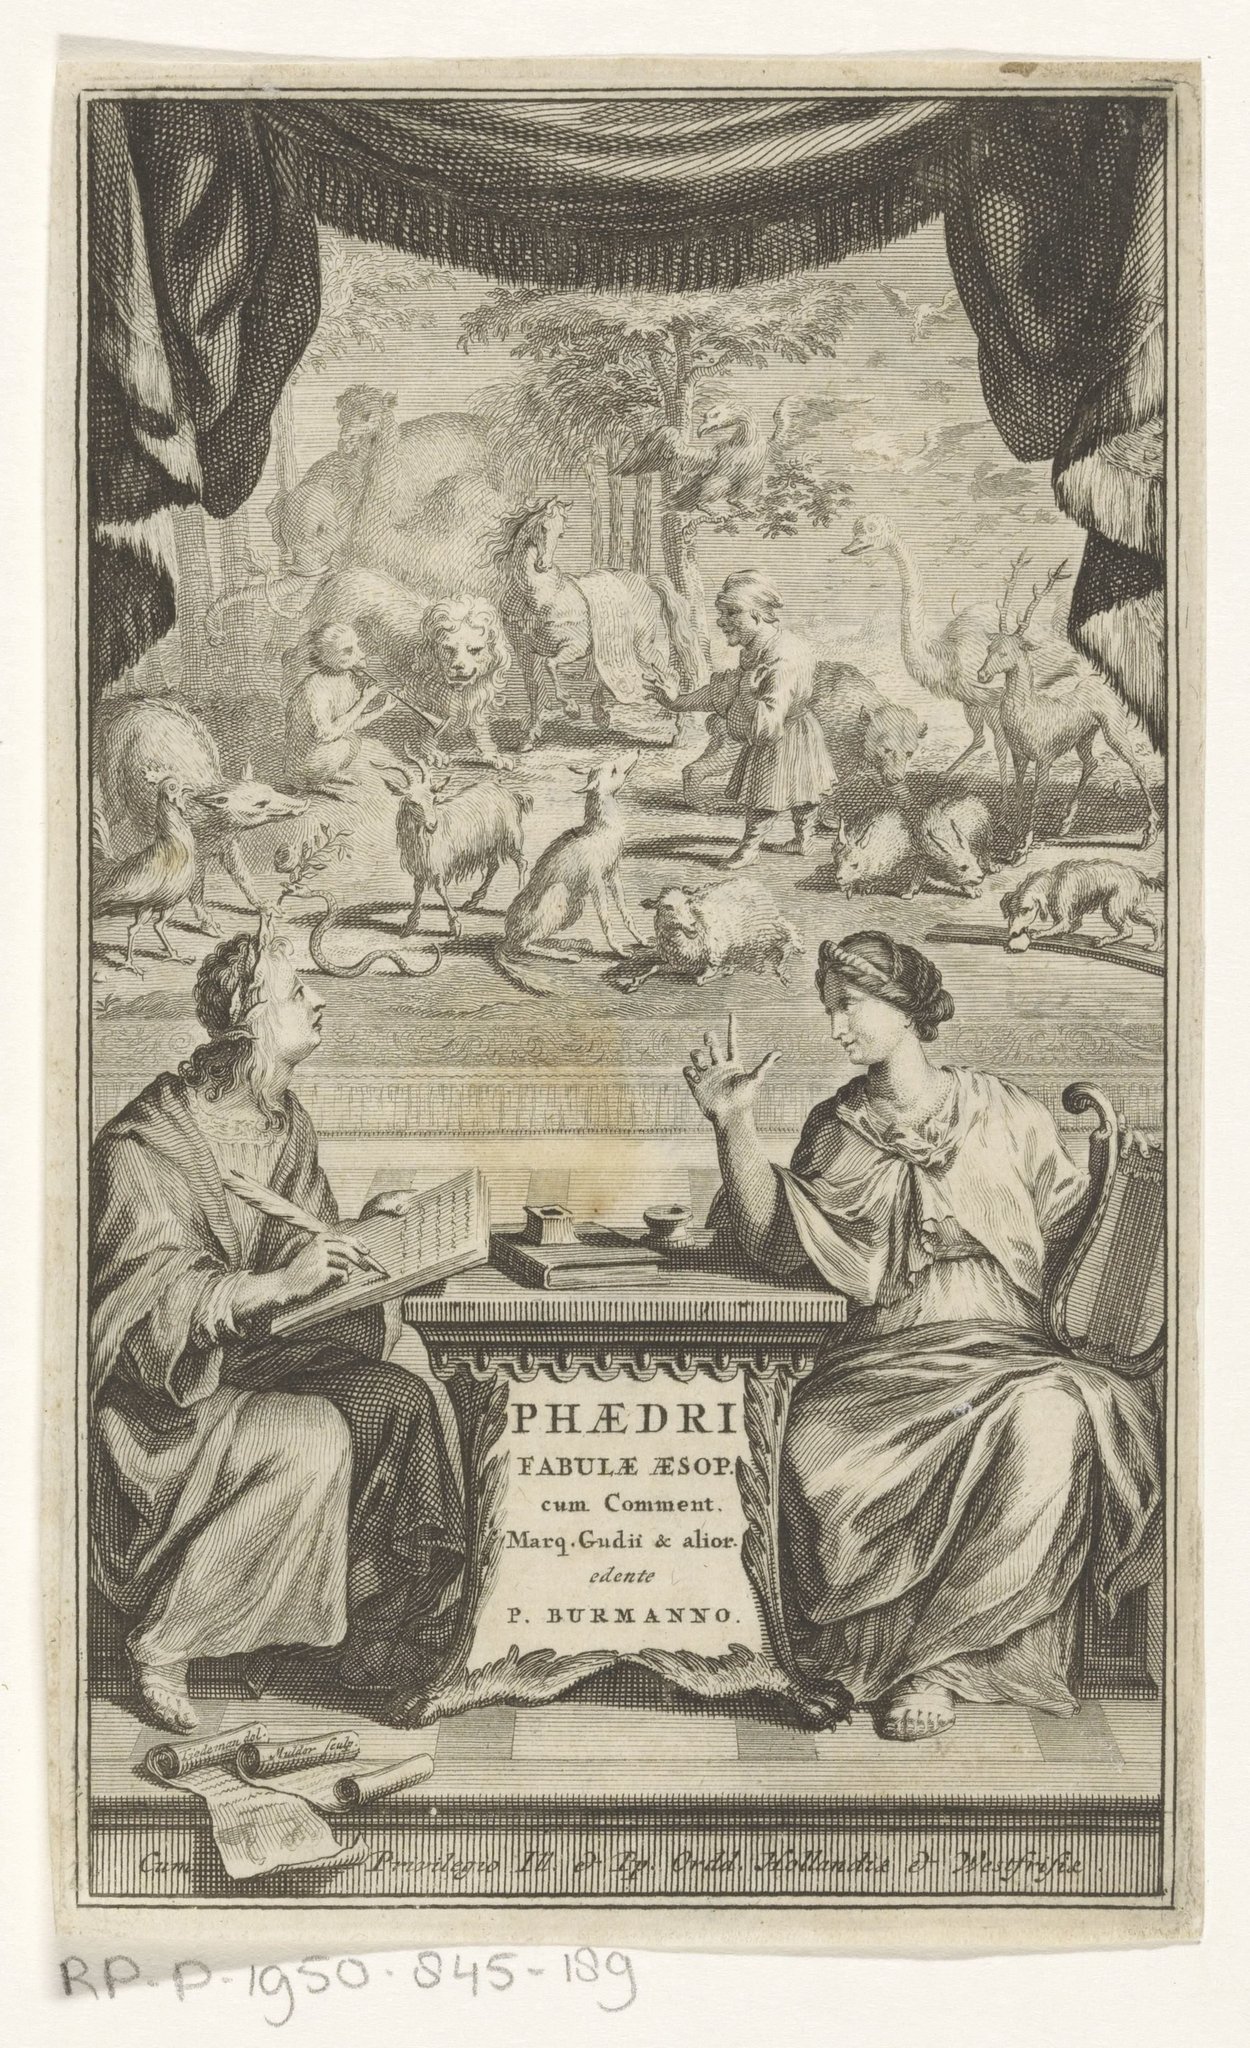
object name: titelblad, titelpagina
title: Titelpagina voor: Pieter Burman, Phaedri fabulae Aesop, 1728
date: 1728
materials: paper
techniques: engraving, etching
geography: leiden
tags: aesopus, fables of aesop : use 85(...), writer, poet, author, terpsichore (one of the muses); 'terpsicore' (ripa)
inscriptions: collector's mark: Lugt 2228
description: Titelpagina voor: Burman, Pieter. Phaedri fabulae Aesop. Leiden: Luchtmans, Samuel (I), 1728. Prent afkomstig uit een plakalbum met titelprenten, ornamenten etc. op blauw papier in 1983 uit elkaar gehaald. Volgens een notitie op verso zat de prent op p. 189 van dit album.